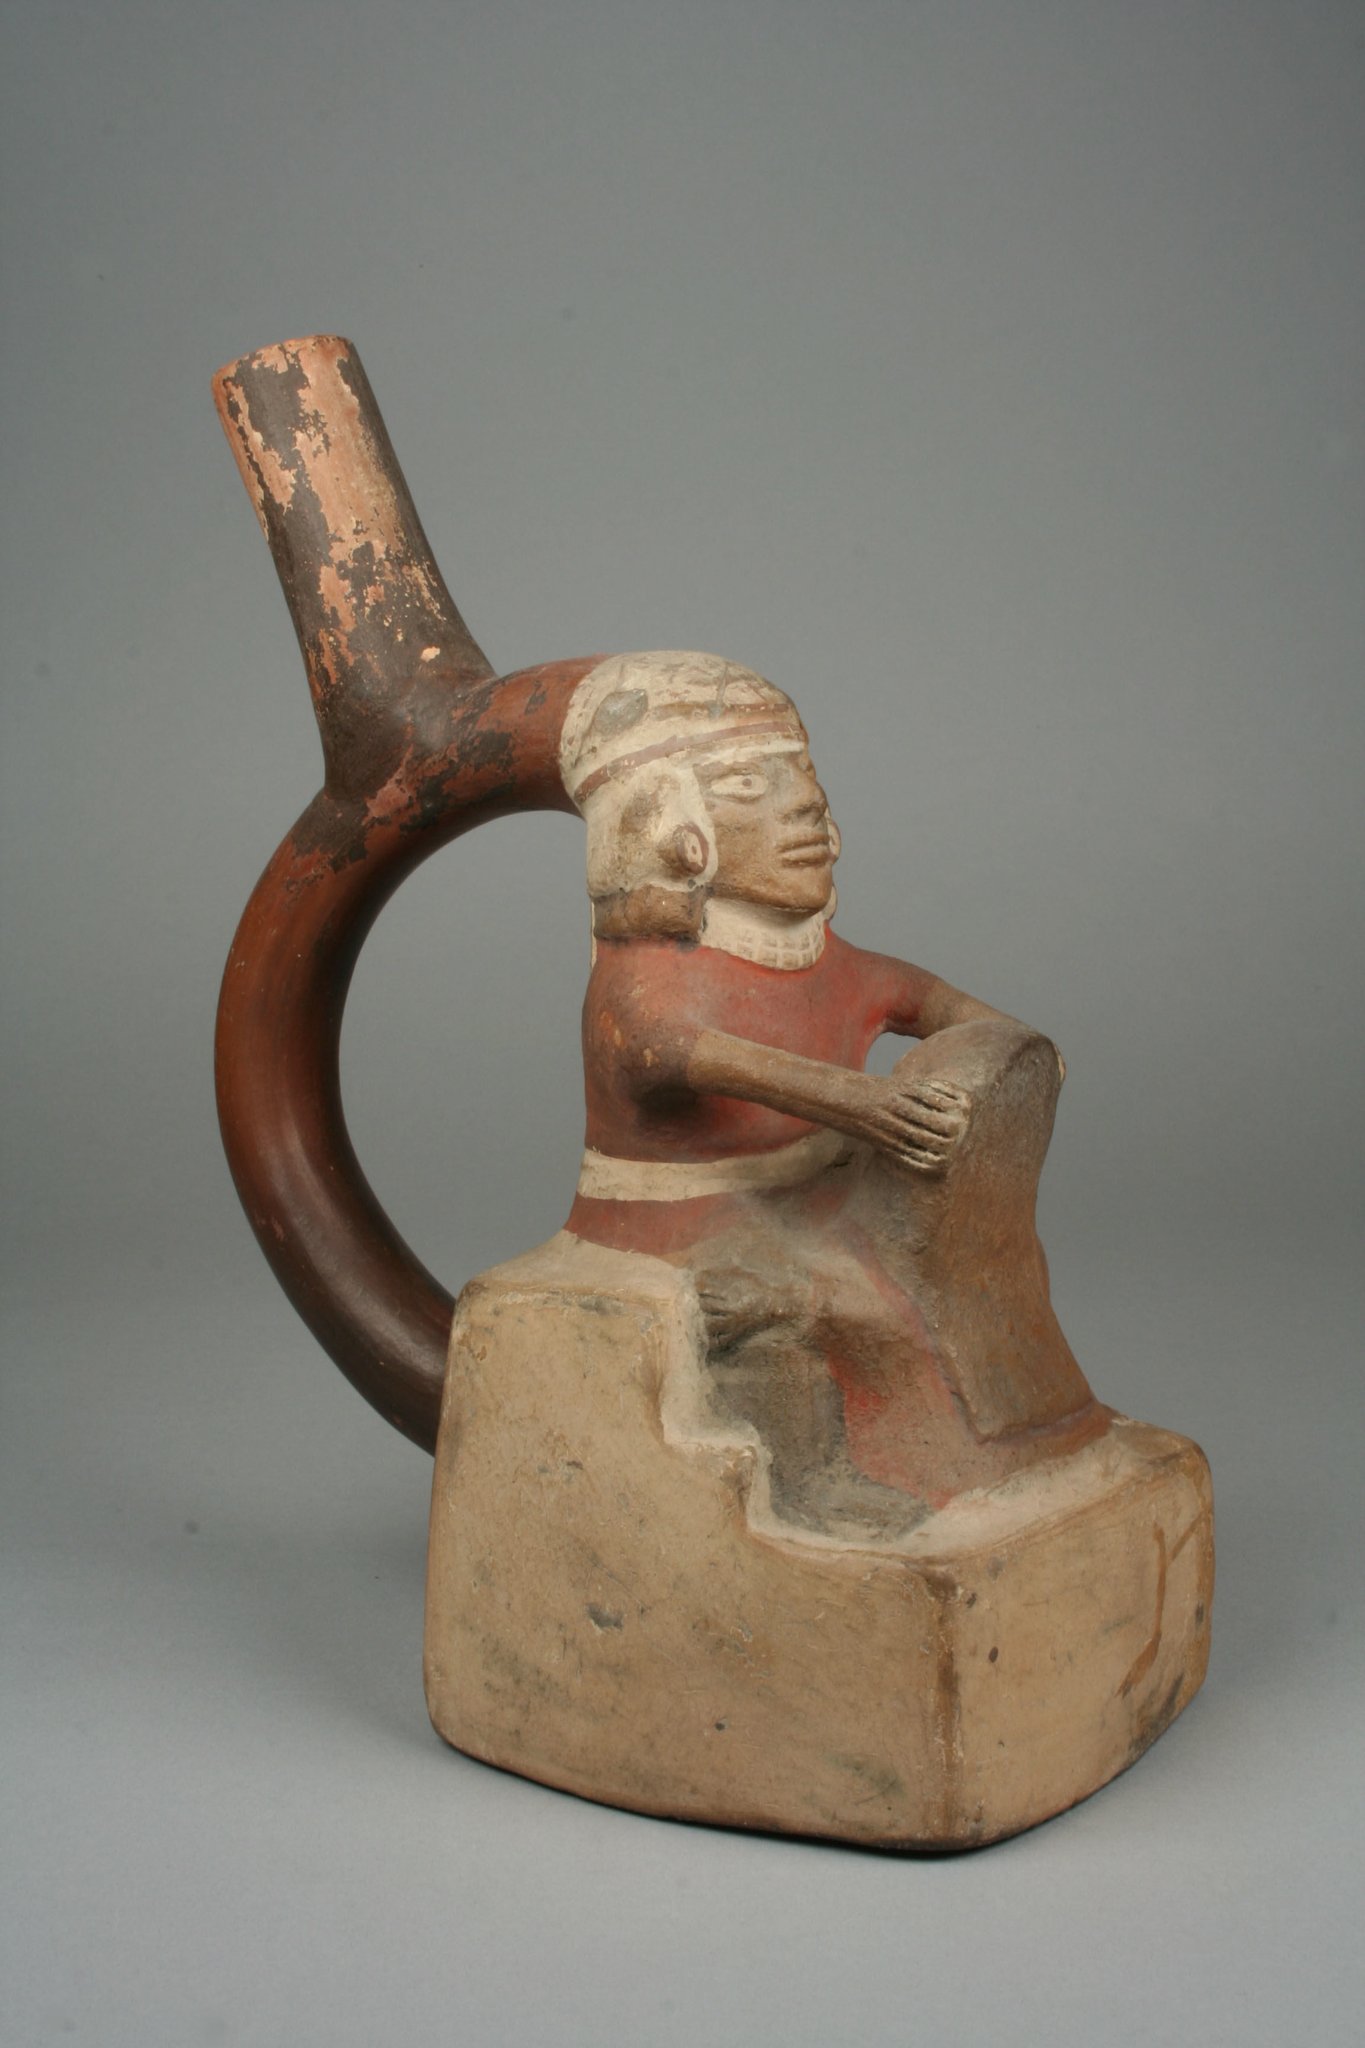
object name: bottle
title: Stirrup Spout Bottle with Couple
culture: moche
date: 301-700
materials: ceramic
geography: peru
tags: men